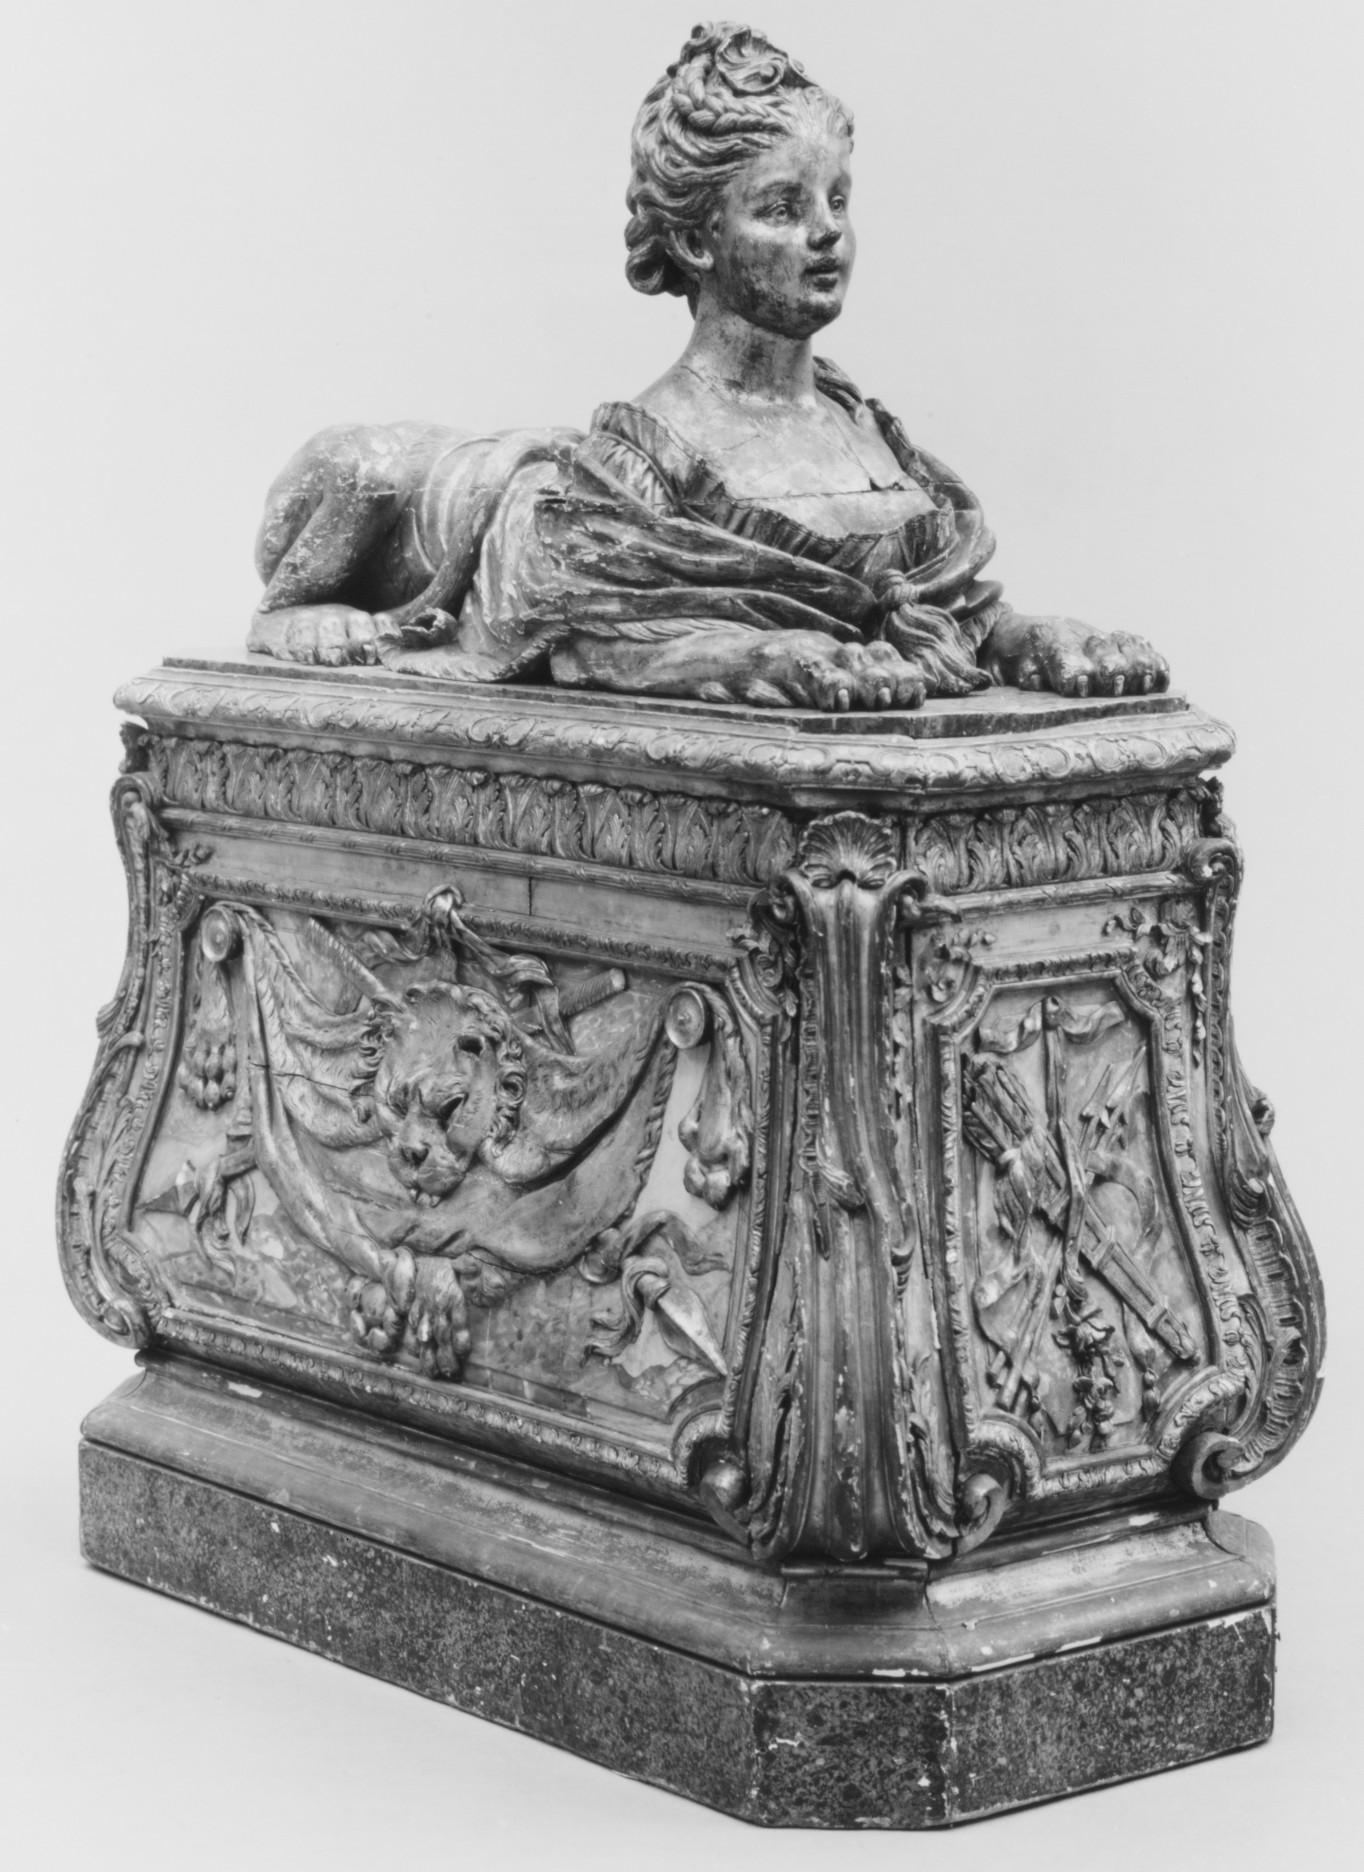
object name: pedestal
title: Sphinx (one of a pair)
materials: wood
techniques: carving, gilding, painting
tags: sphinx